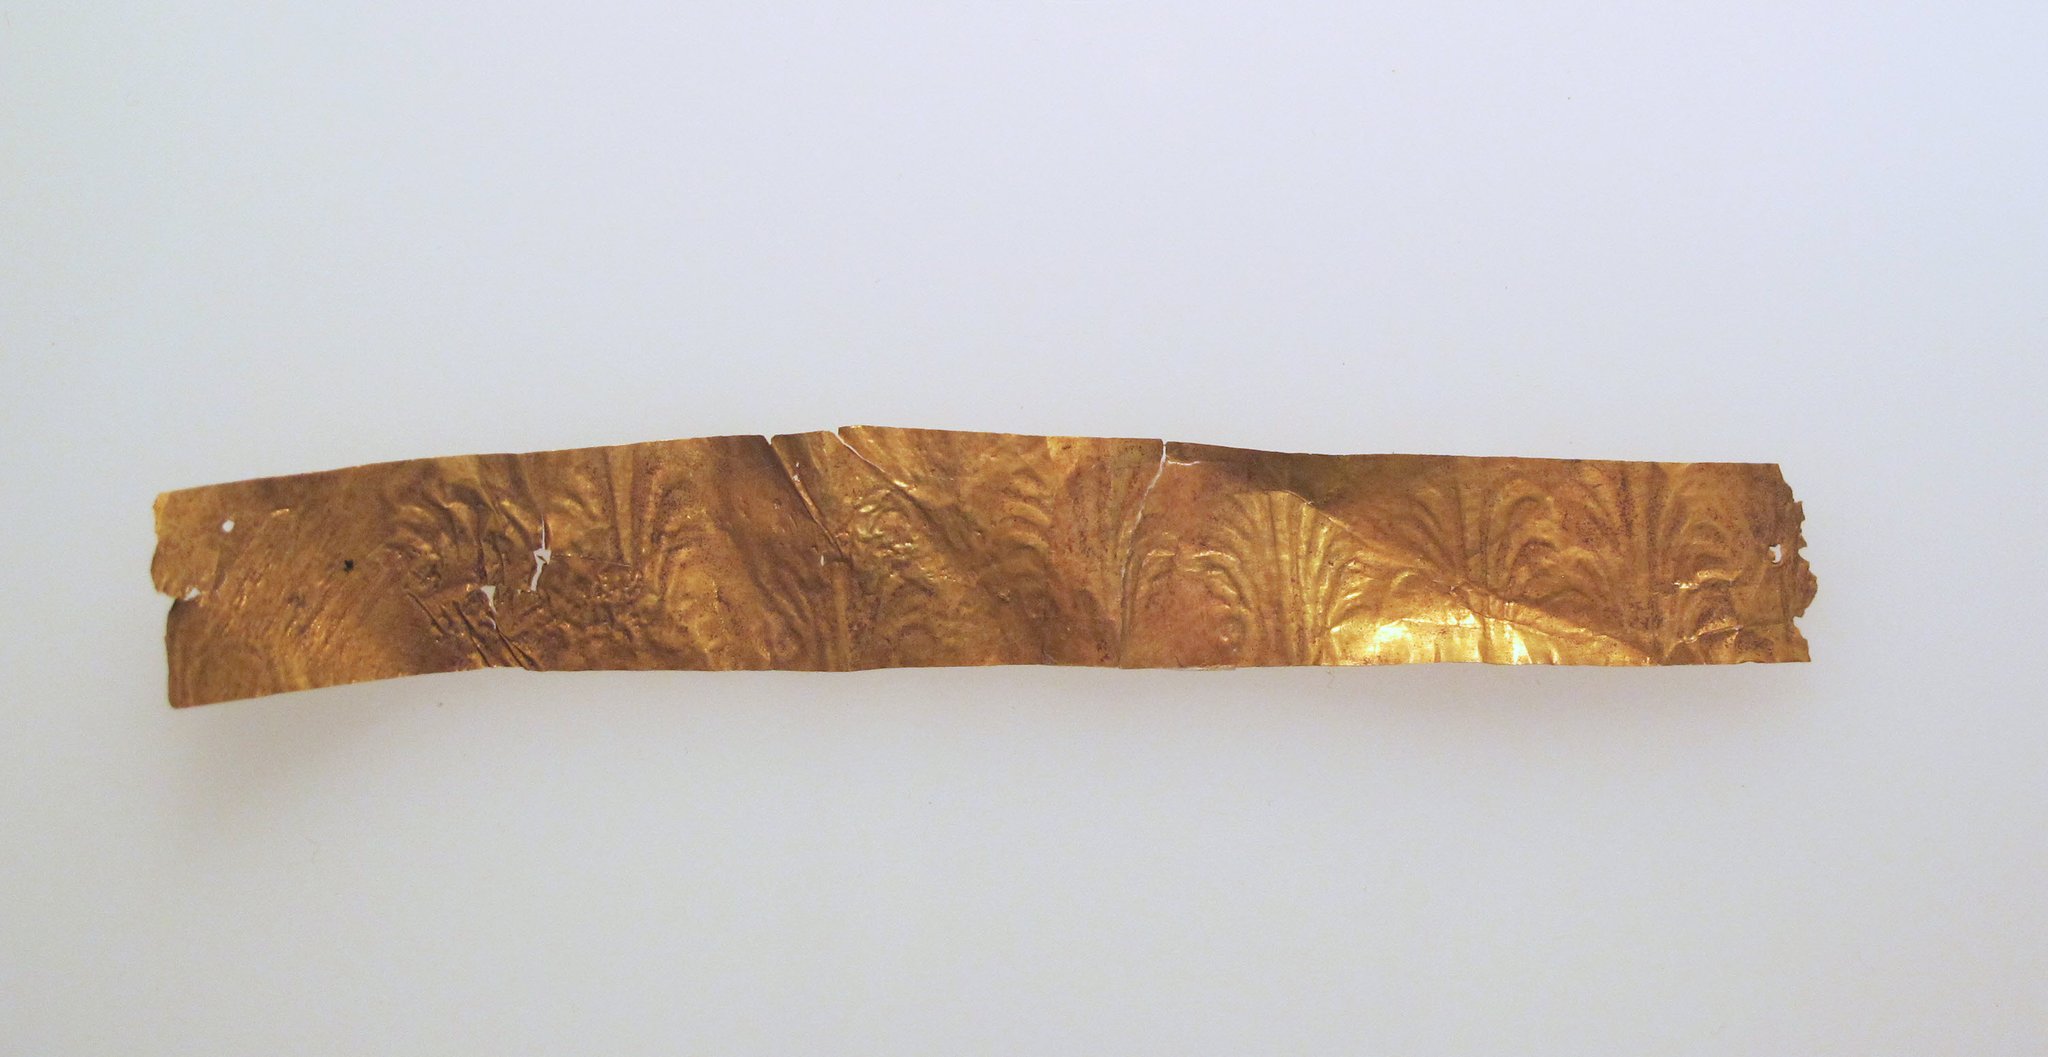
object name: frontlet of gold leaf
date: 7000 BCE-330 CE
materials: gold